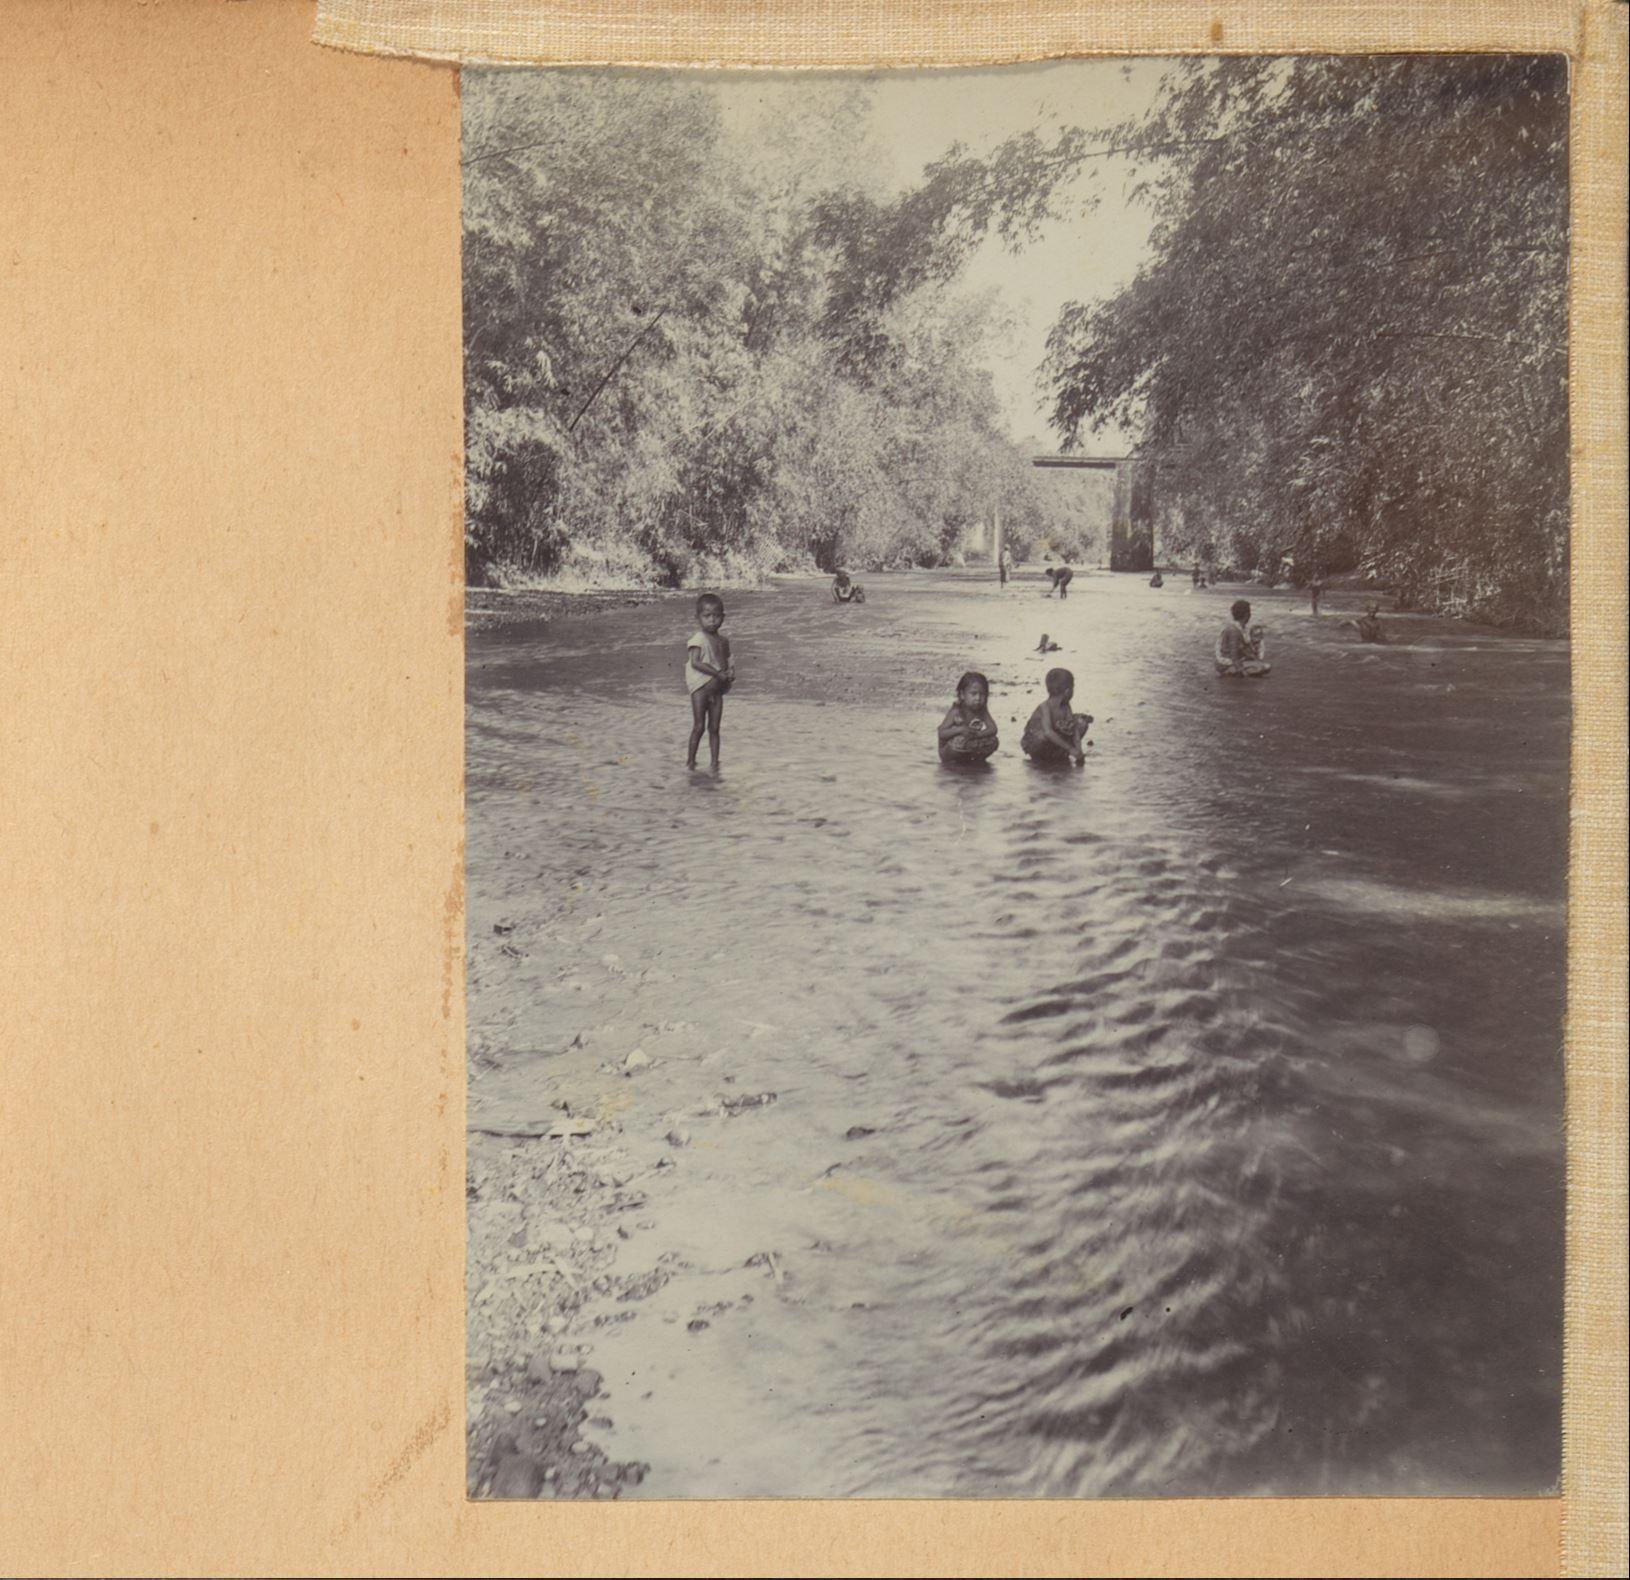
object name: photograph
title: Kinderen spelend in een rivier in Nederlands-Indië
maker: Anonymous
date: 1917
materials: photographic support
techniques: gelatin silver print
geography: dutch east indies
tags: child, swimming (movement in water), river (+ landscape with figures, staffage), dutch east indies, the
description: Onderdeel van Familiealbum met foto's van een familie in de voormalige kolonie Nederlands-Indië en van een suikerfabriek in Purworejo.